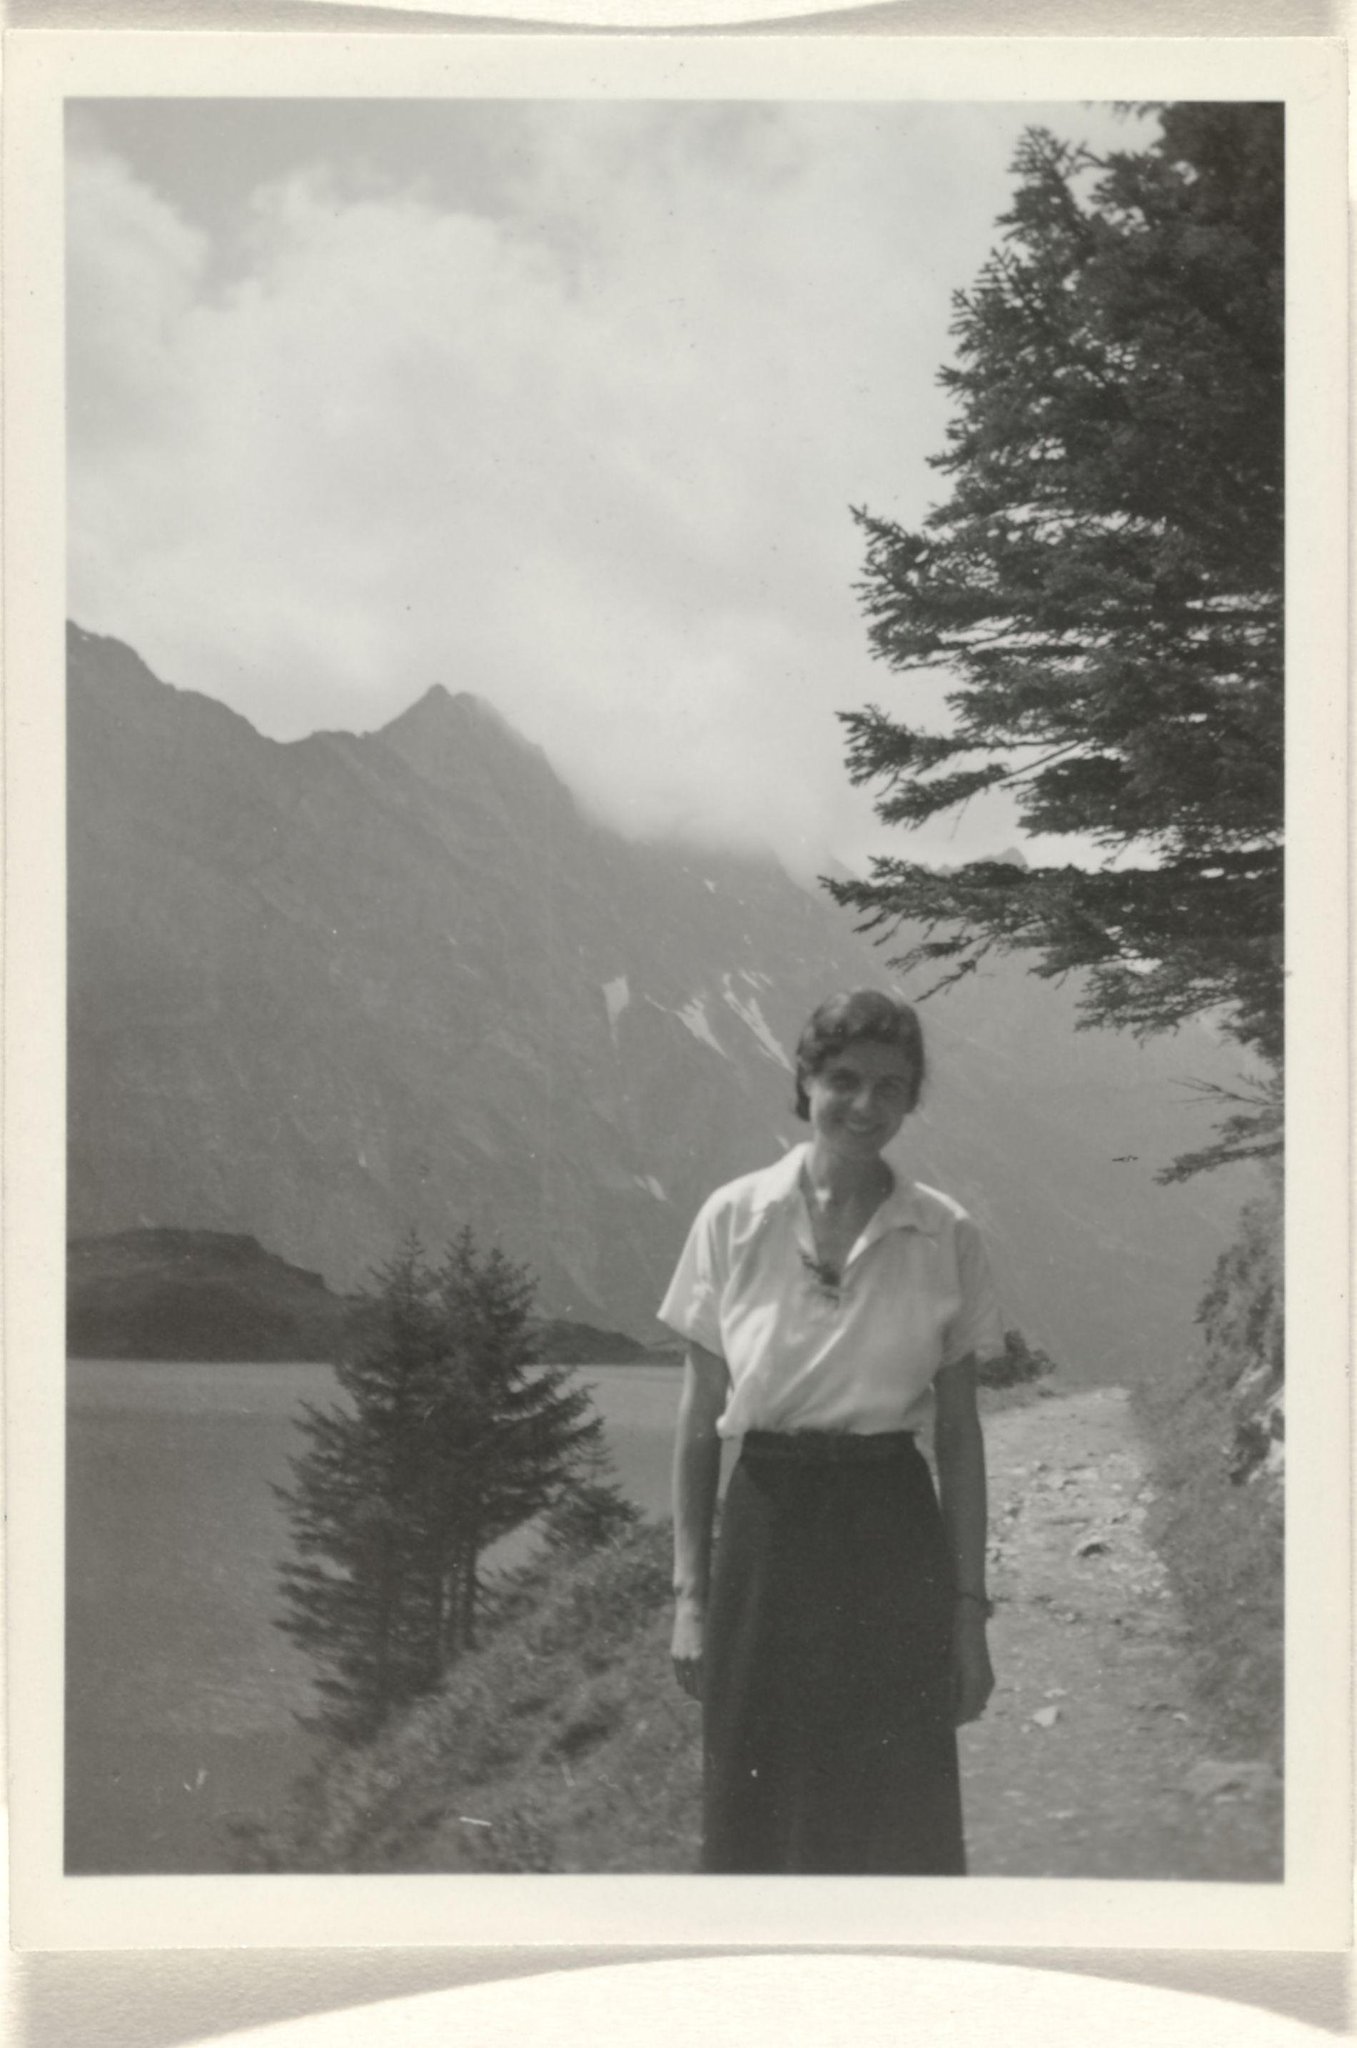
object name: photograph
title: Lid van de huishoudelijk staf van de familie Wachenheimer, mogelijk het kindermeisje staande op een pad naast een meer en voor bergen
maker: Anonymous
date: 1908-1935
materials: photographic support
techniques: gelatin silver print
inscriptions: date: ‘Aug.35. 93’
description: Onbekend lid van de huishoudelijk staf van de familie Wachenheimer, mogelijk het kindermeisje, in licht hemd en donkere rok staande op een pad naast een meer en voor bergen.